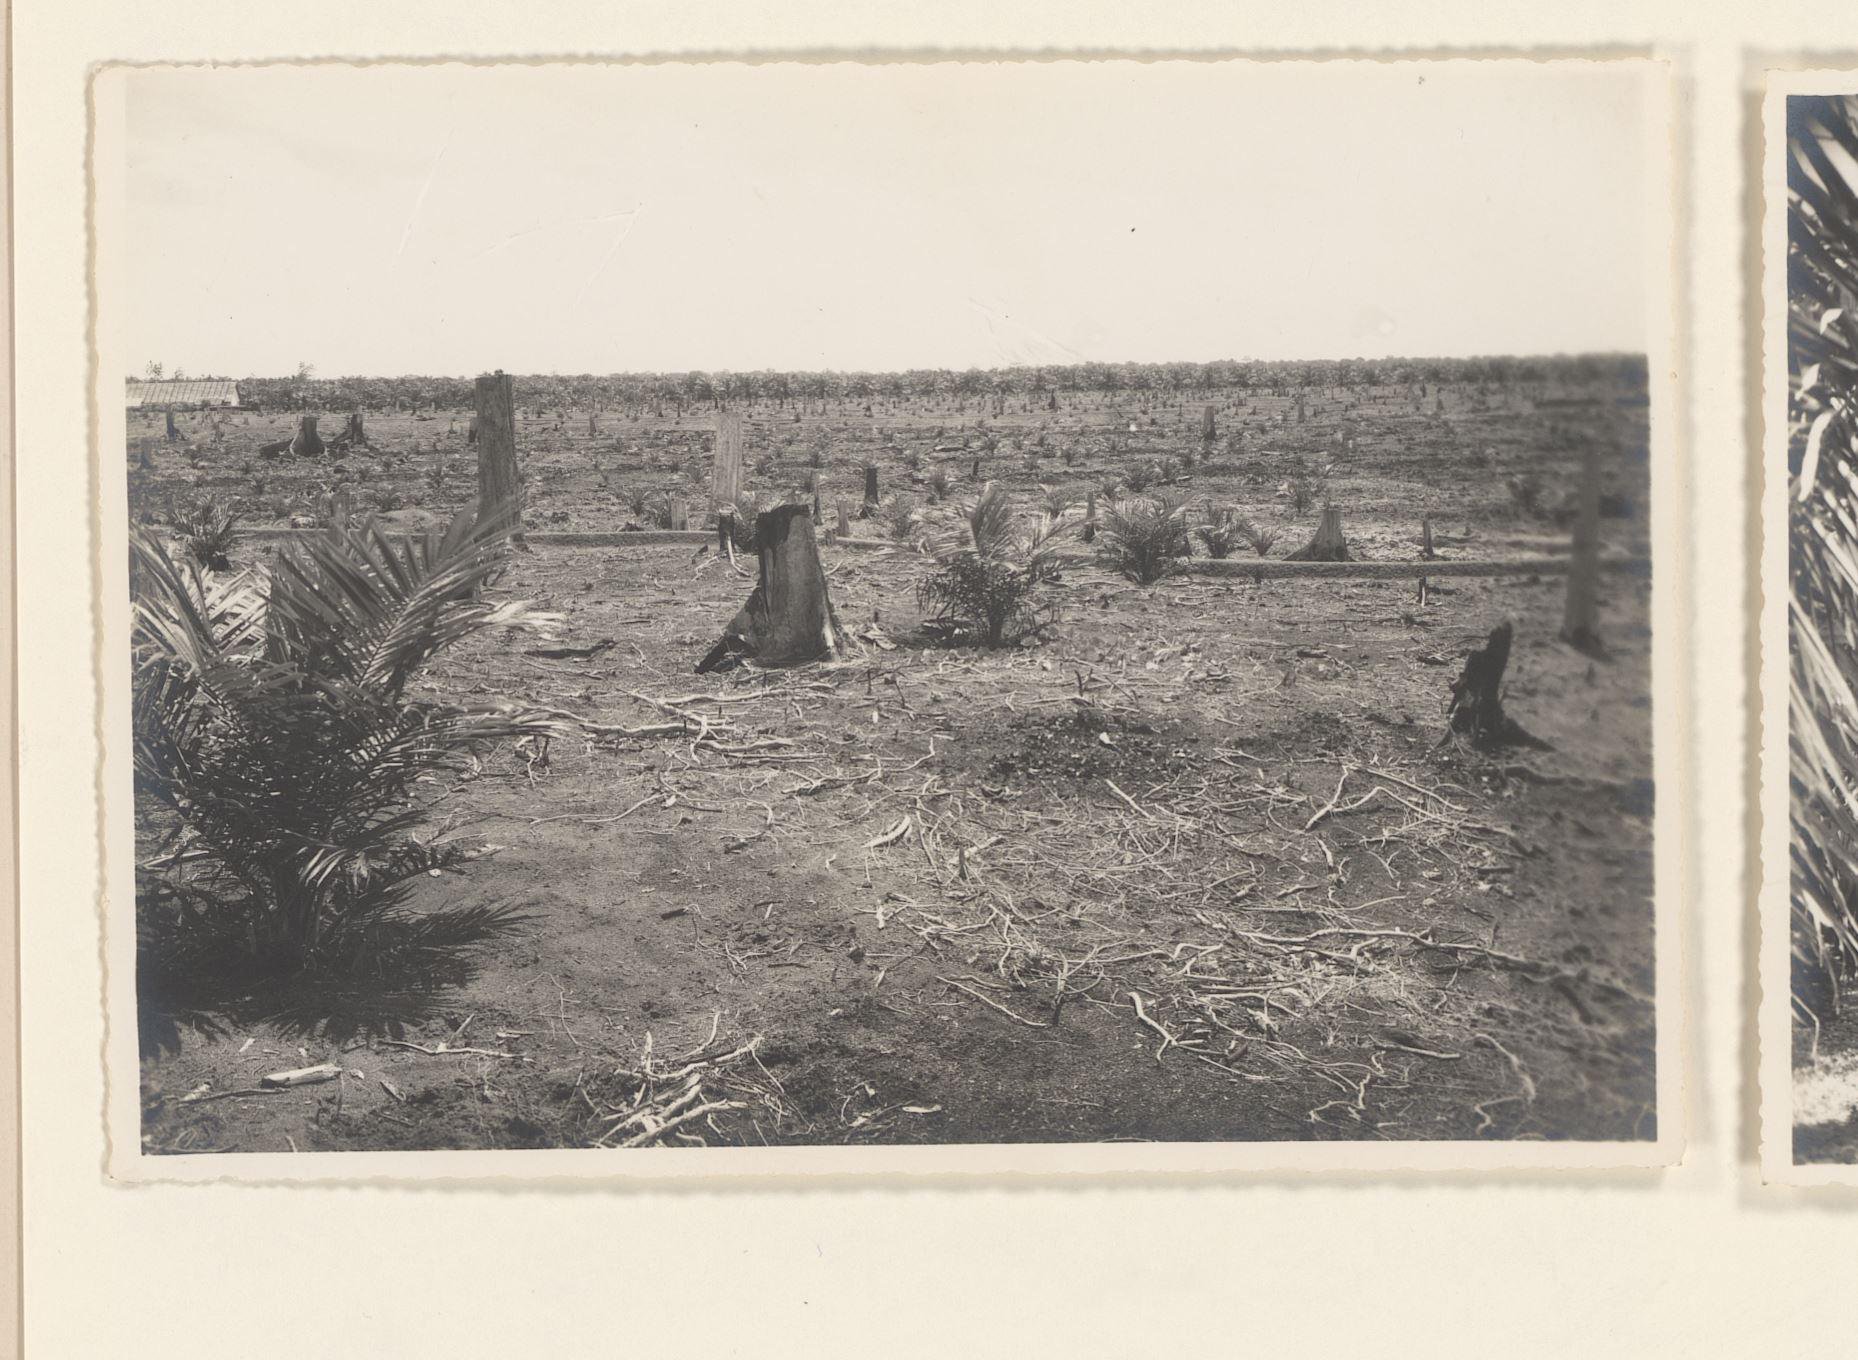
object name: photograph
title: Oliepalmenaanplant op Padang Halaban, 1938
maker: Anonymous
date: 1907-1938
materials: photographic support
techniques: gelatin silver print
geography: sumatra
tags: plantation, (non-fruit) products of plants or trees: palm oil, sumatra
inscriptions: inscription: ‘ontginning 1937 Padang Halaban Juli '38’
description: Oliepalmenaanplant op Padang Halaban, juli 1938. Tweede afdruk, los in melinexhoesje, van een foto ingeplakt op albumblad 9. Onderdeel van het fotoalbum over de plantages Pernantian en Brussel van de Sumatra Caoutchouc Maatschappij op de Oostkust van Sumatra in de jaren 1935-1939.